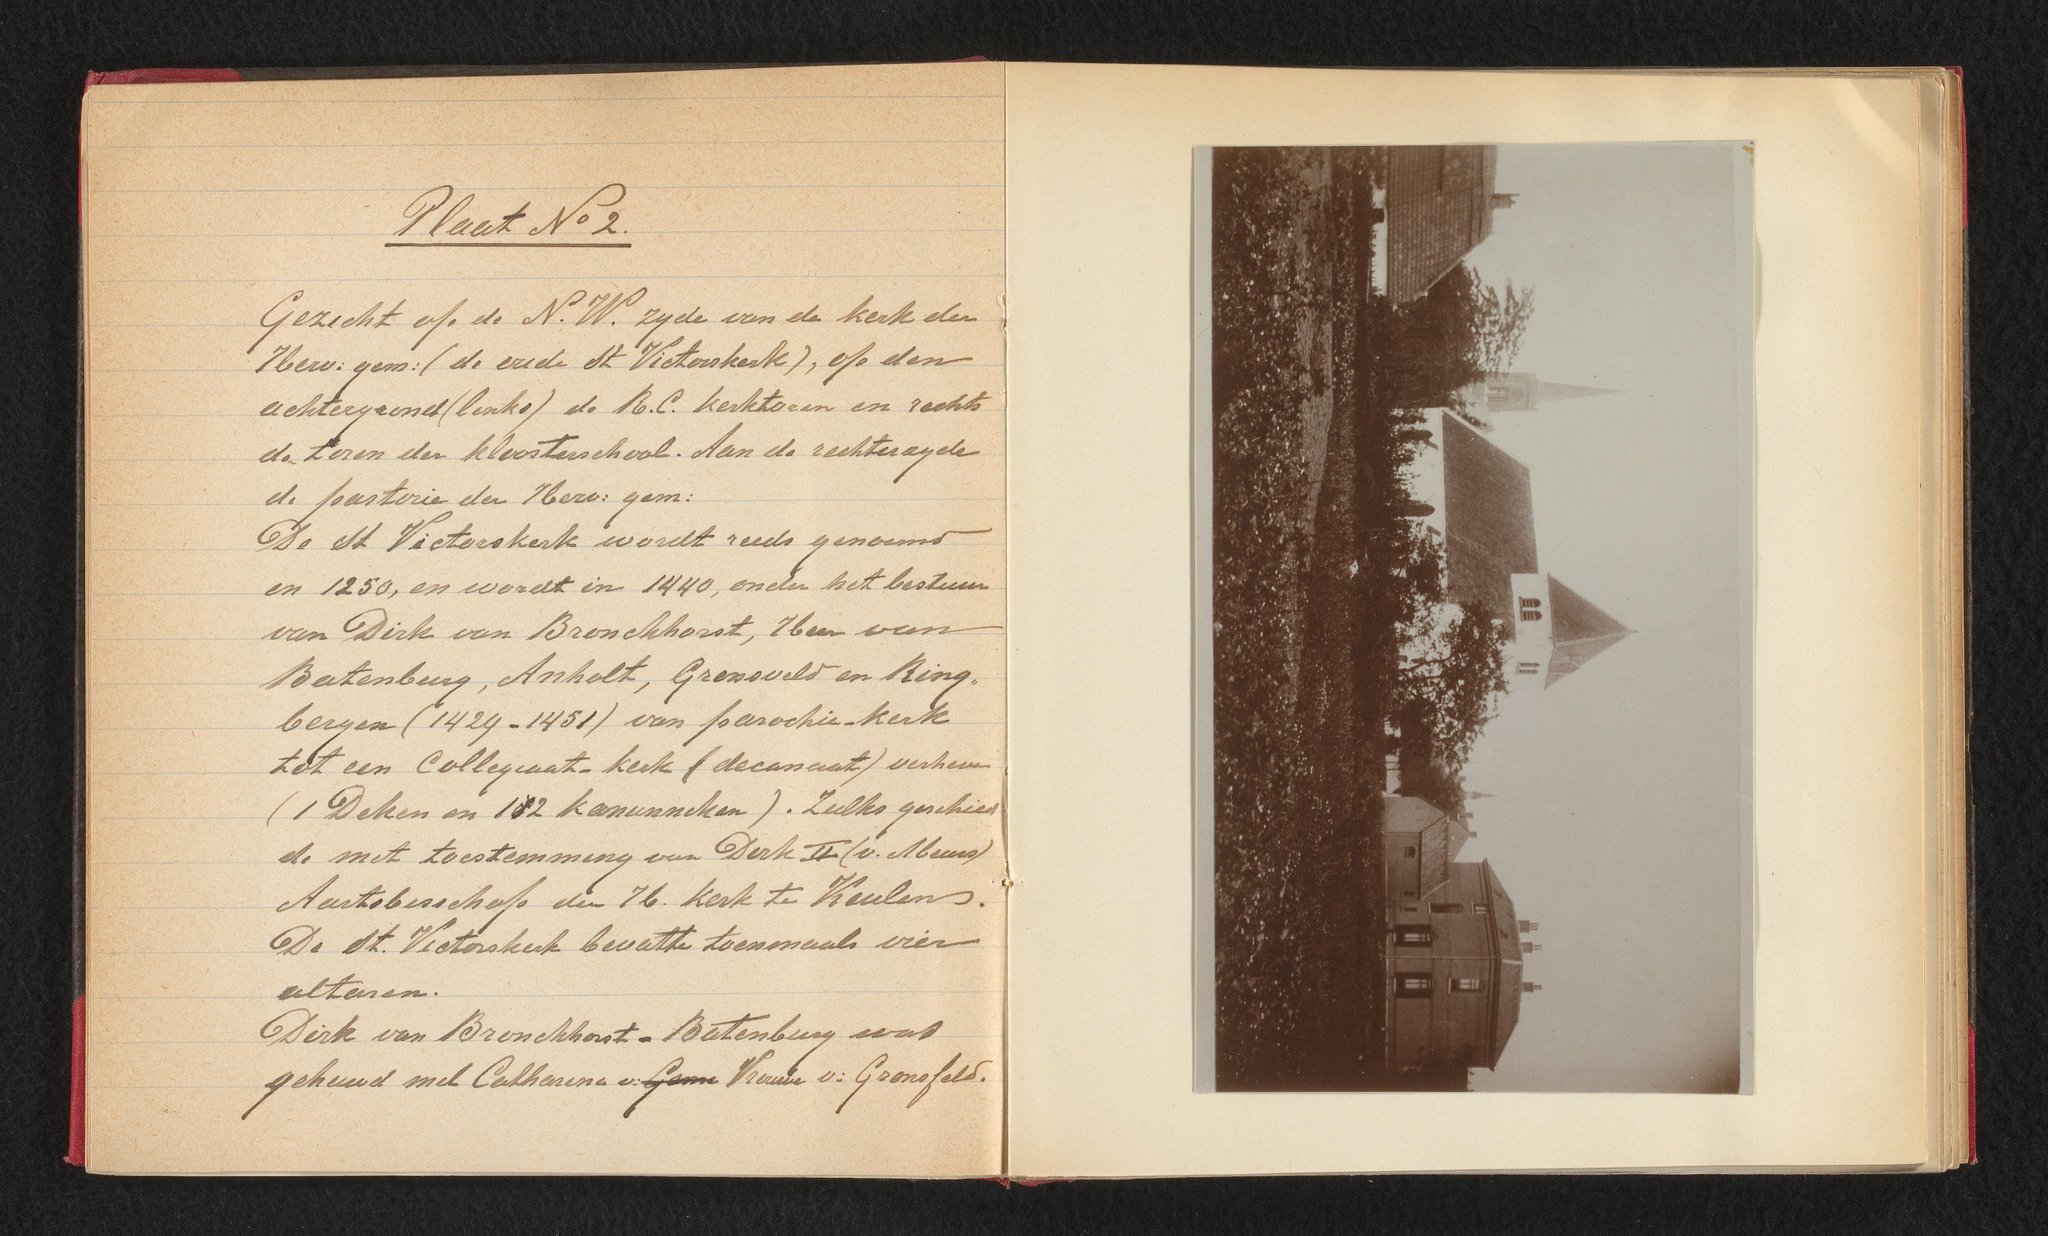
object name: photograph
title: Gezicht op Batenburg, in de verte de toren van de Sint-Victorkerk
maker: benjamin charlé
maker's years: 1845-1925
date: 1902-1907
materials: paper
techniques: collodion silver print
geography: batenburg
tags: church (exterior)